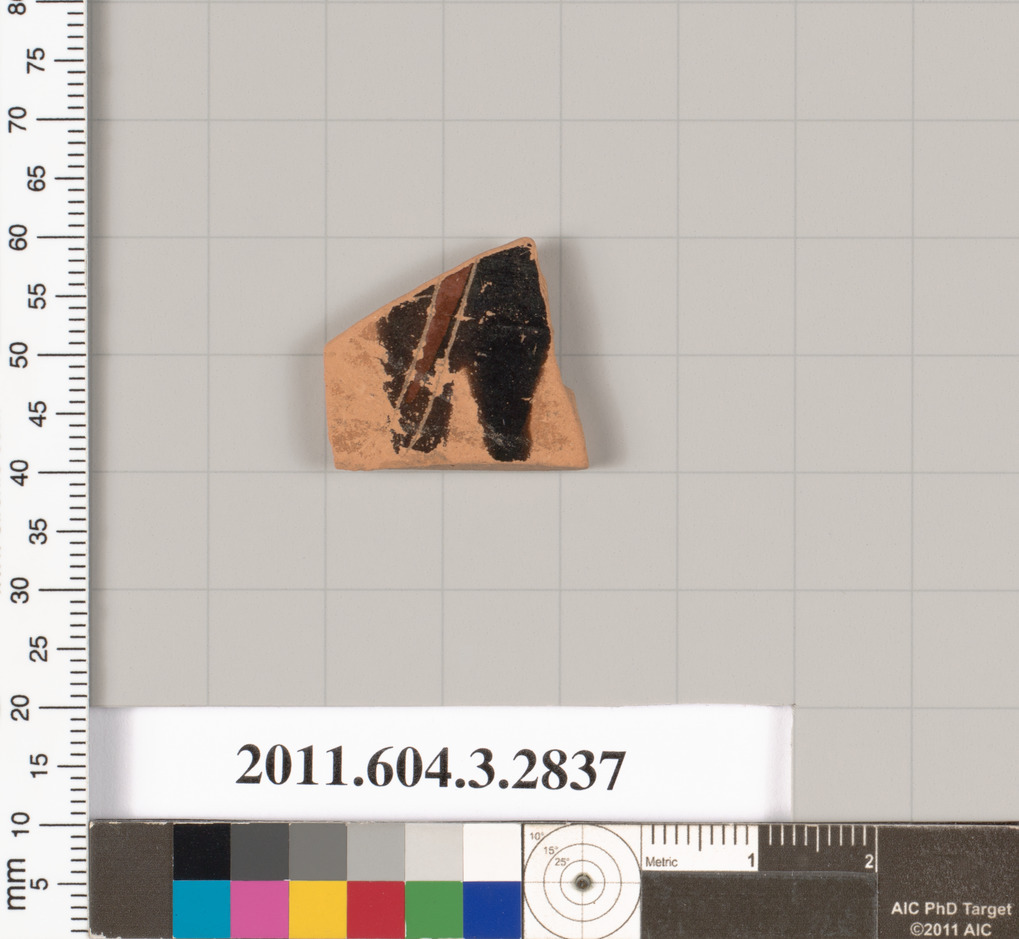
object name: undetermined closed shape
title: Terracotta fragment of a closed shape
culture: greek, attic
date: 534-468 BCE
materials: terracotta